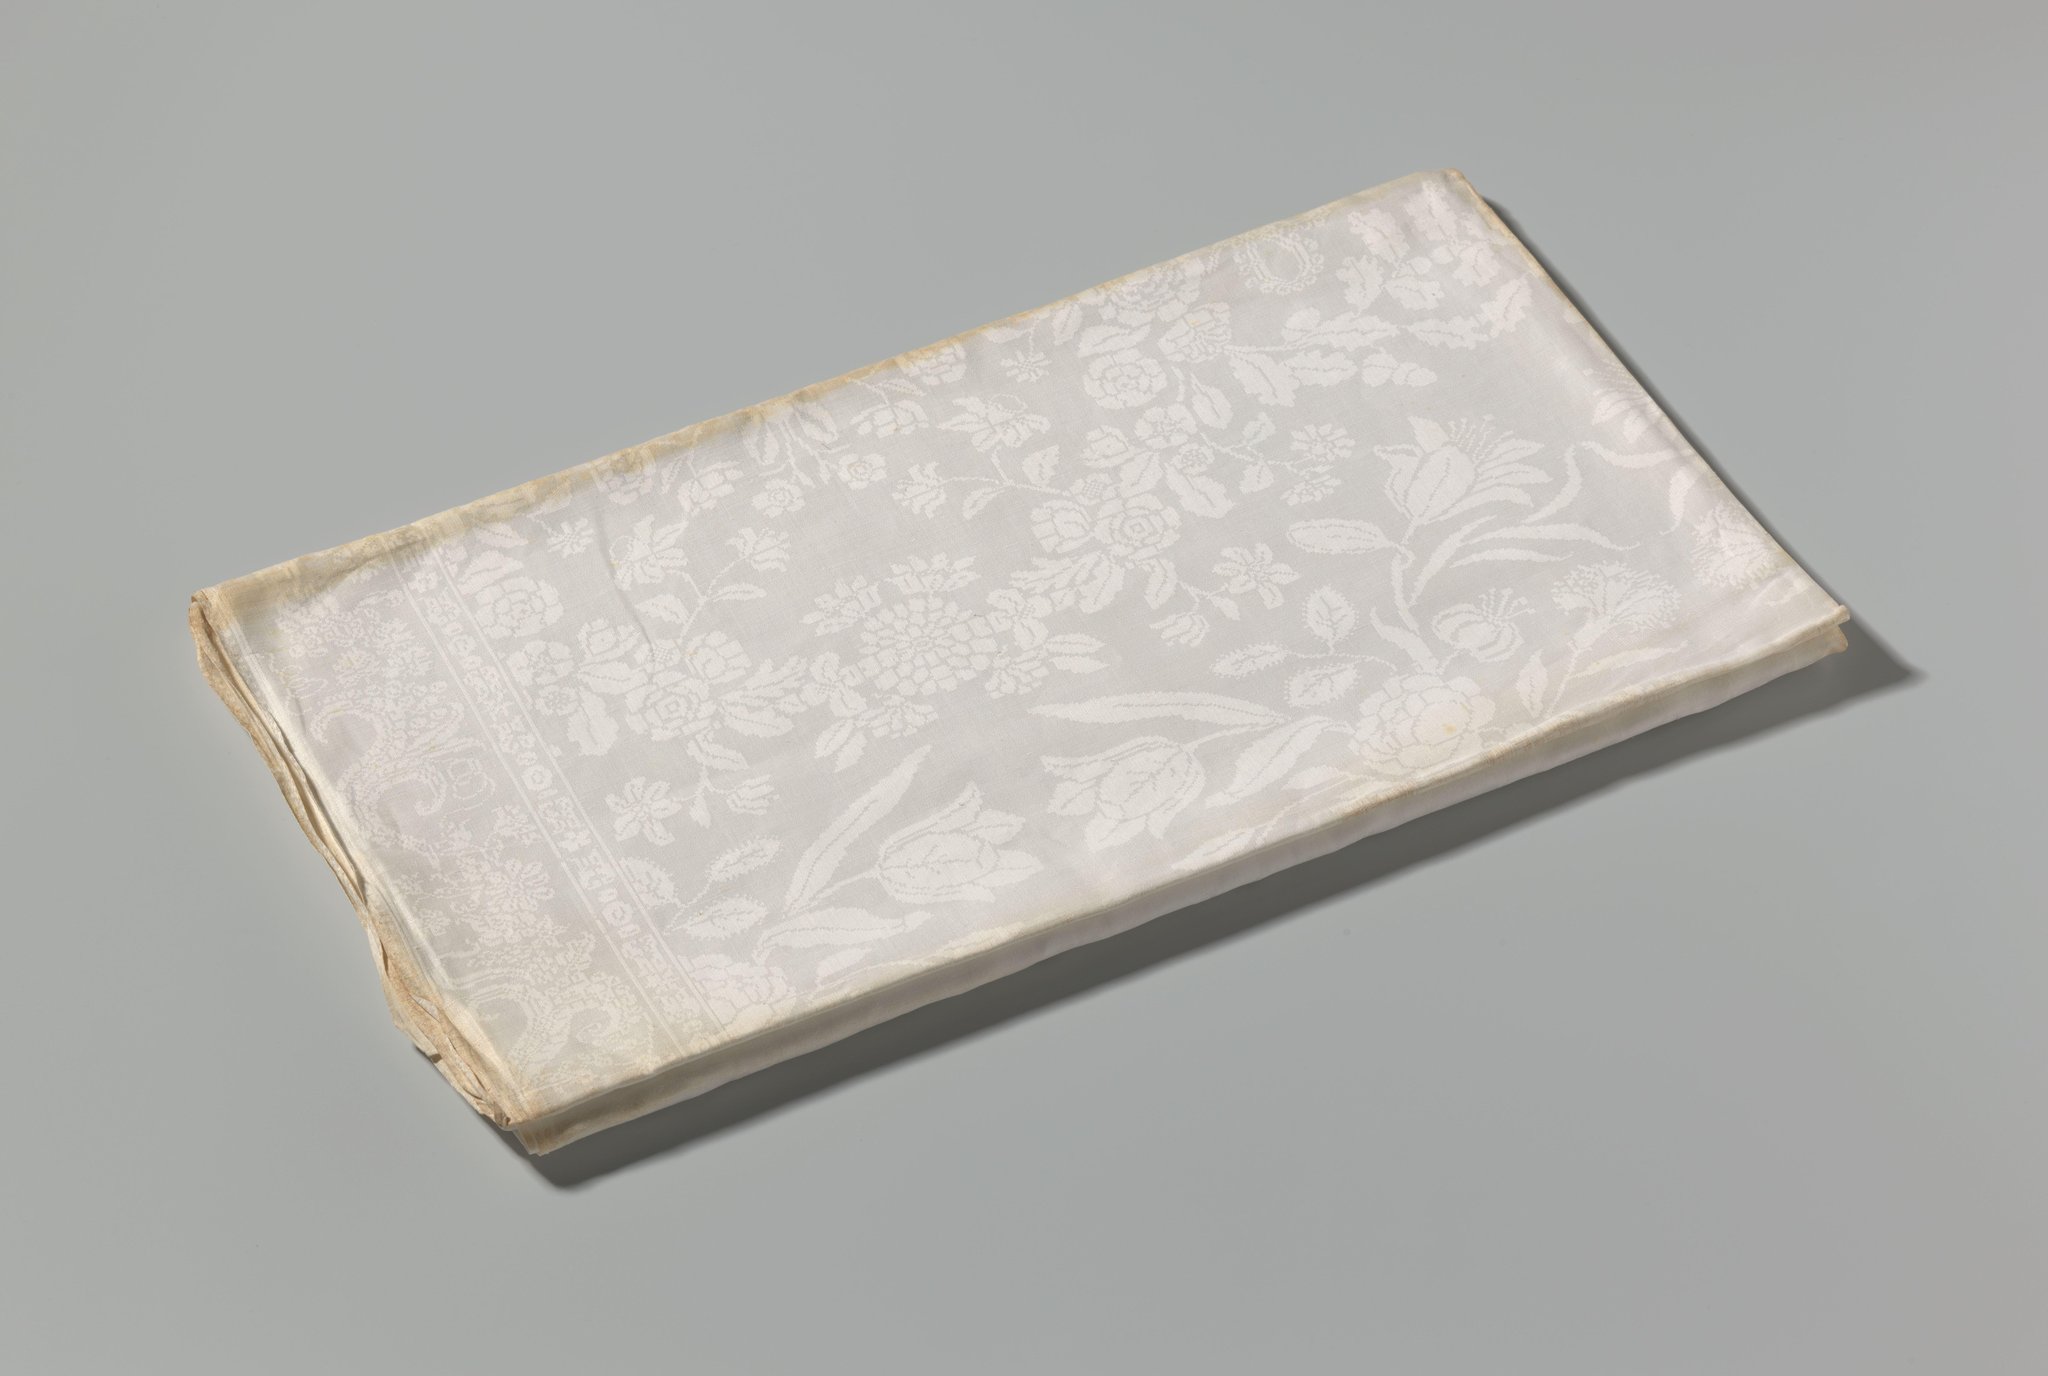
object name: tablecloth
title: Tafellaken van linnendamast met een bloempatroon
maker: Anonymous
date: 1680-1690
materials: linen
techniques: damask, weave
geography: northern netherlands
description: Tafellaken van linnendamast met bloemkransen en bloemboeketten. In de hoeken een gekroond monogram.